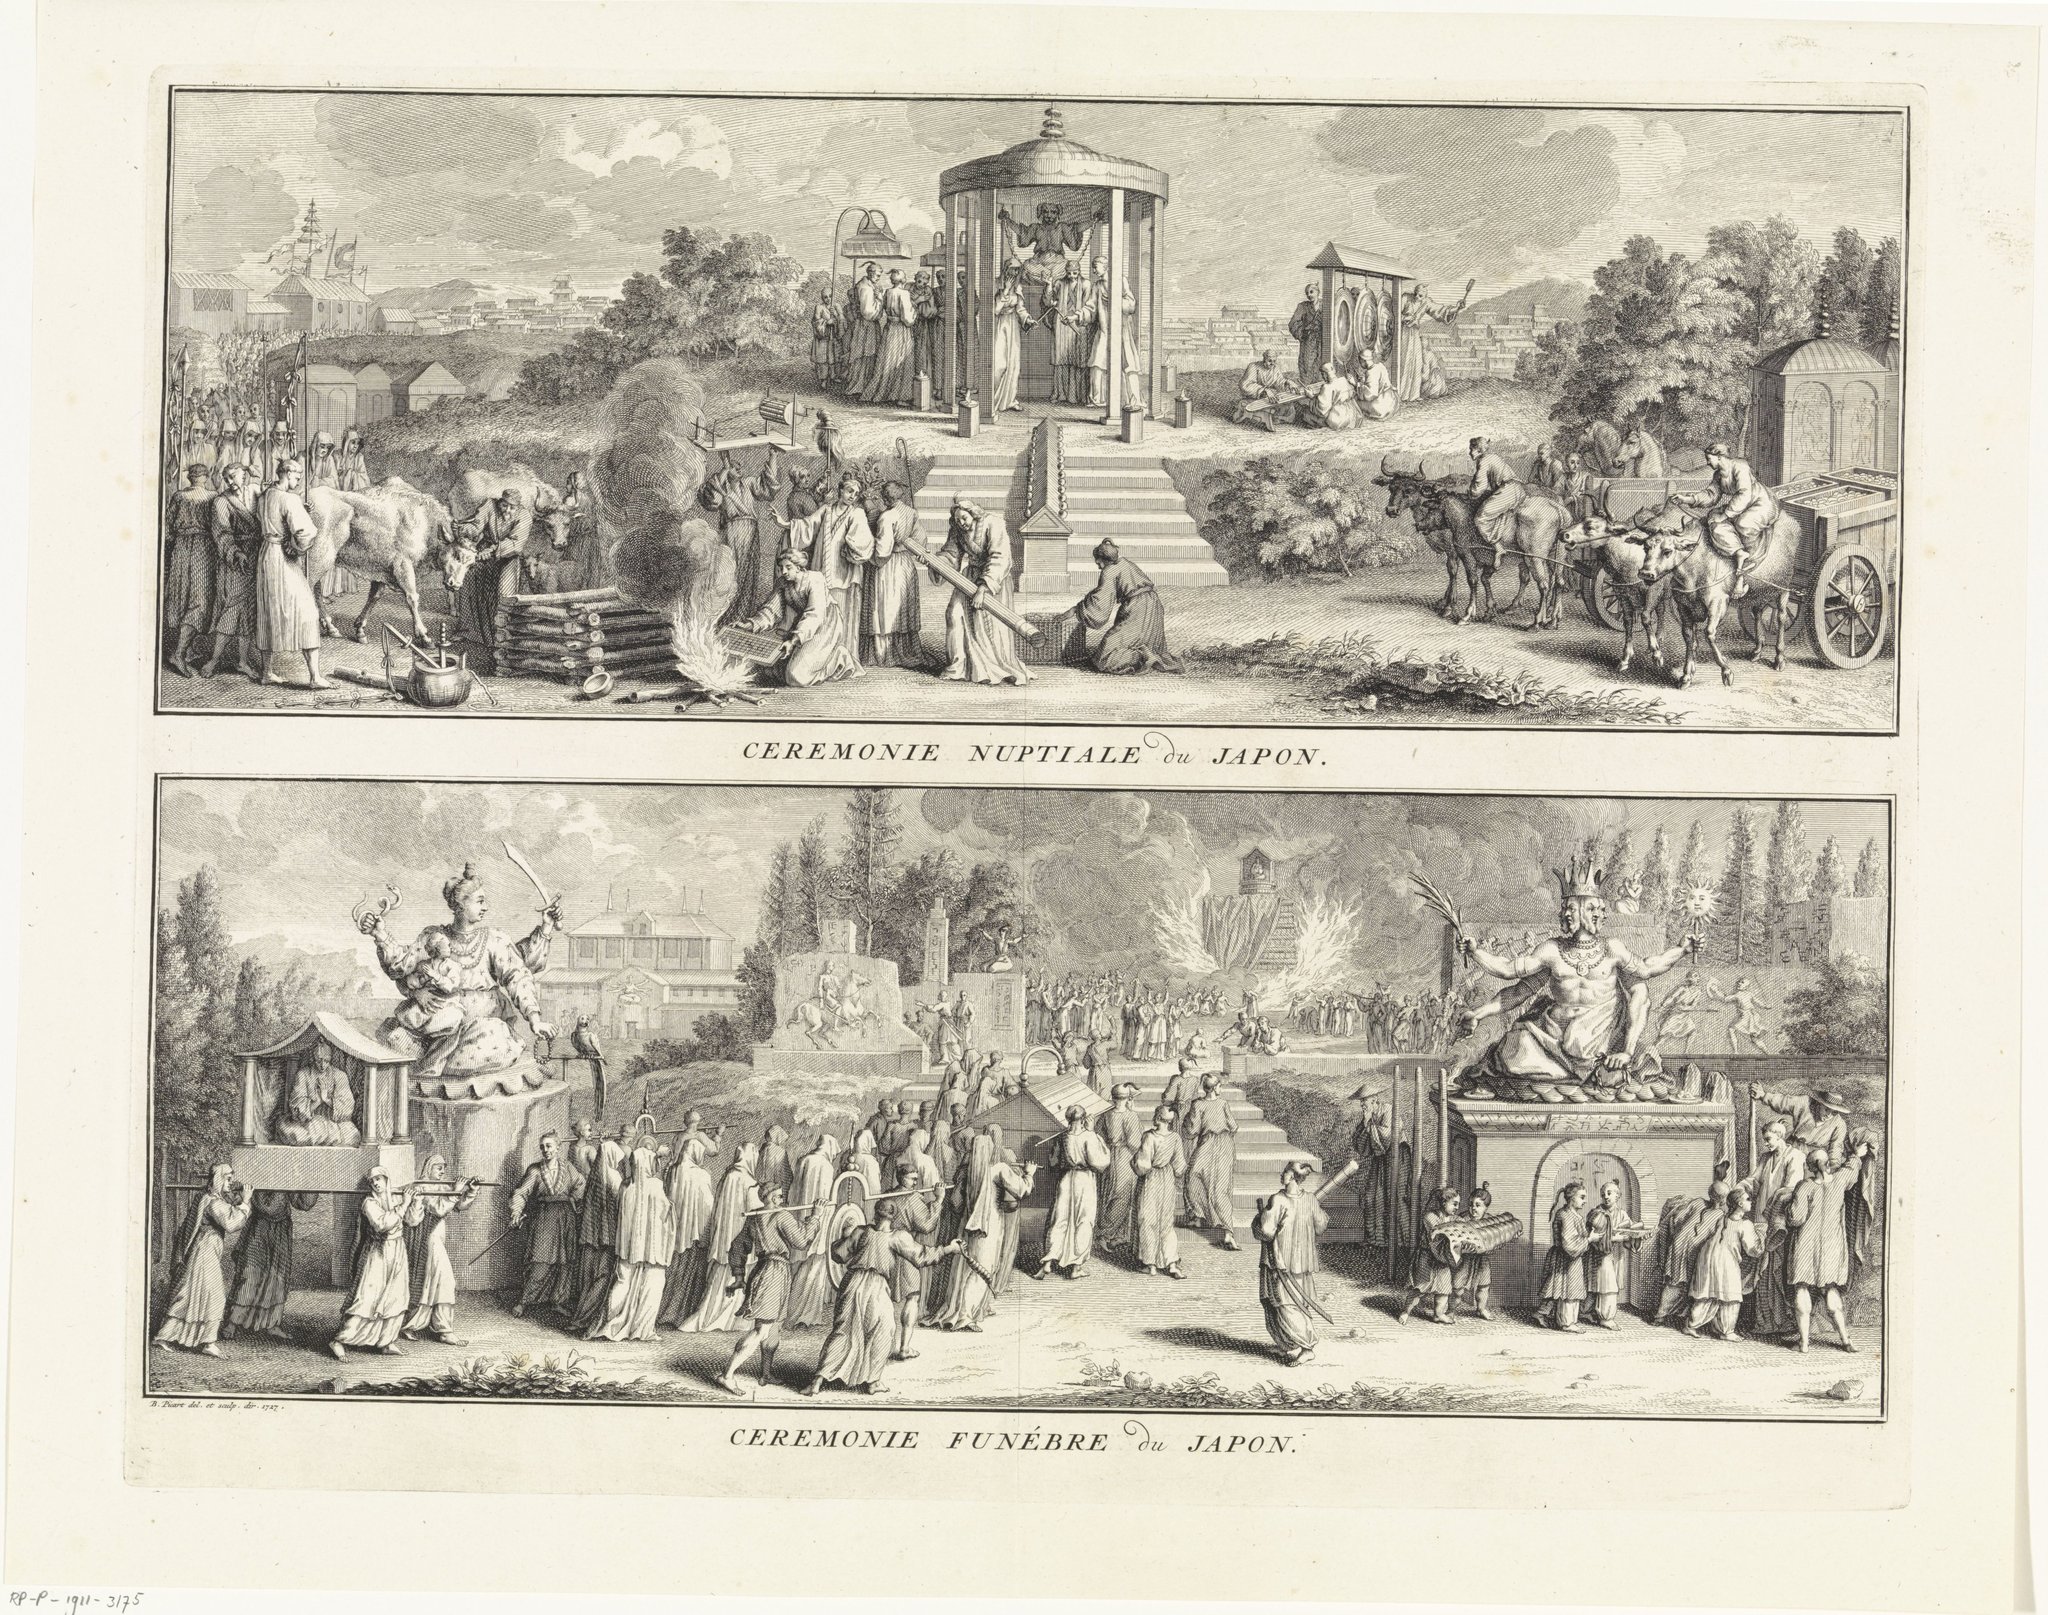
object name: print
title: Ceremonie Nuptiale du Japon / Ceremonie Funébre du Japon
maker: bernard picart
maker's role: draughtsman, print maker, publisher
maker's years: 1673-1733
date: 1727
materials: paper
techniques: engraving, etching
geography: amsterdam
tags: ritual practices ~ shinto, funerary ceremonial, (civil) marriage ceremonies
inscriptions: collector's mark: Lugt 2228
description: Blad met twee voorstellingen. Boven: In een heiligdom op een heuvel wordt een Japans huwelijk voltrokken. Rechts op de voorgrond wordt geofferd. Onder: Een Japanse begrafenis. De stoet met de kist trekt richting de brandstapel, waar de kist verbrand zal worden.